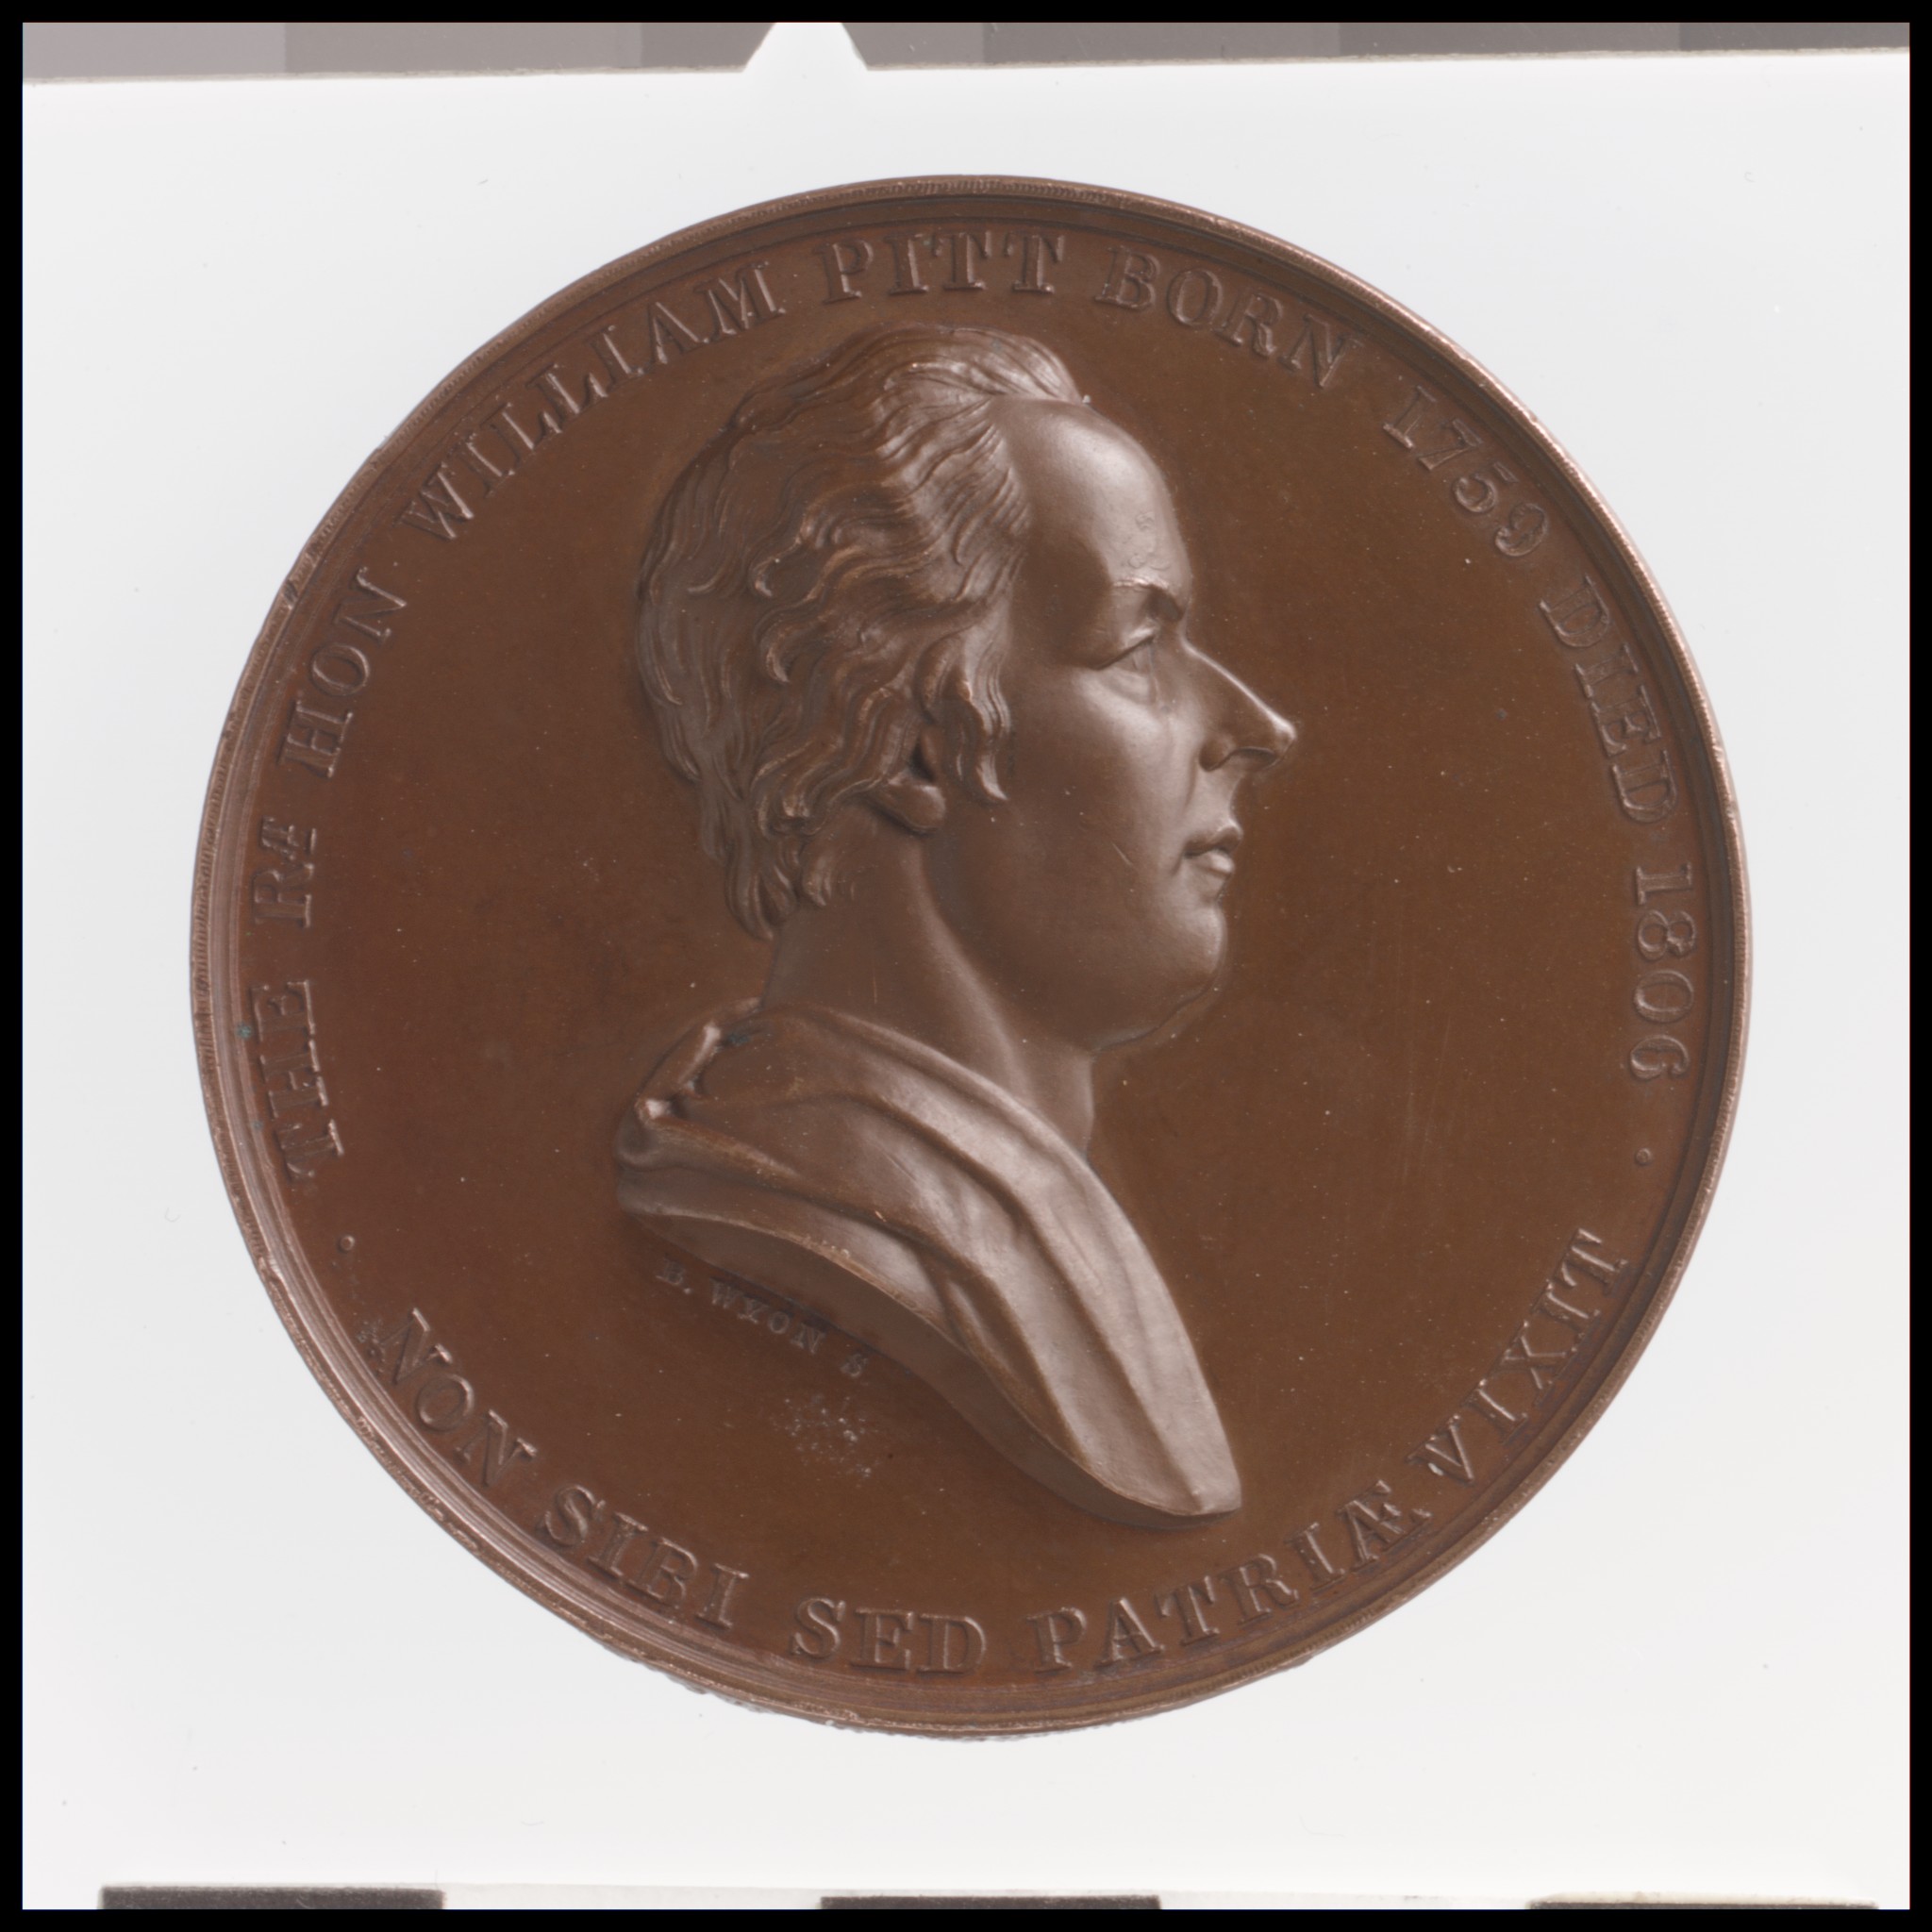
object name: medal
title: Medal Commemorating the Death of William Pitt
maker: benjamin wyon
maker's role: artist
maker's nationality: british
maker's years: 1802-1858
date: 1806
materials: bronze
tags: men,profiles